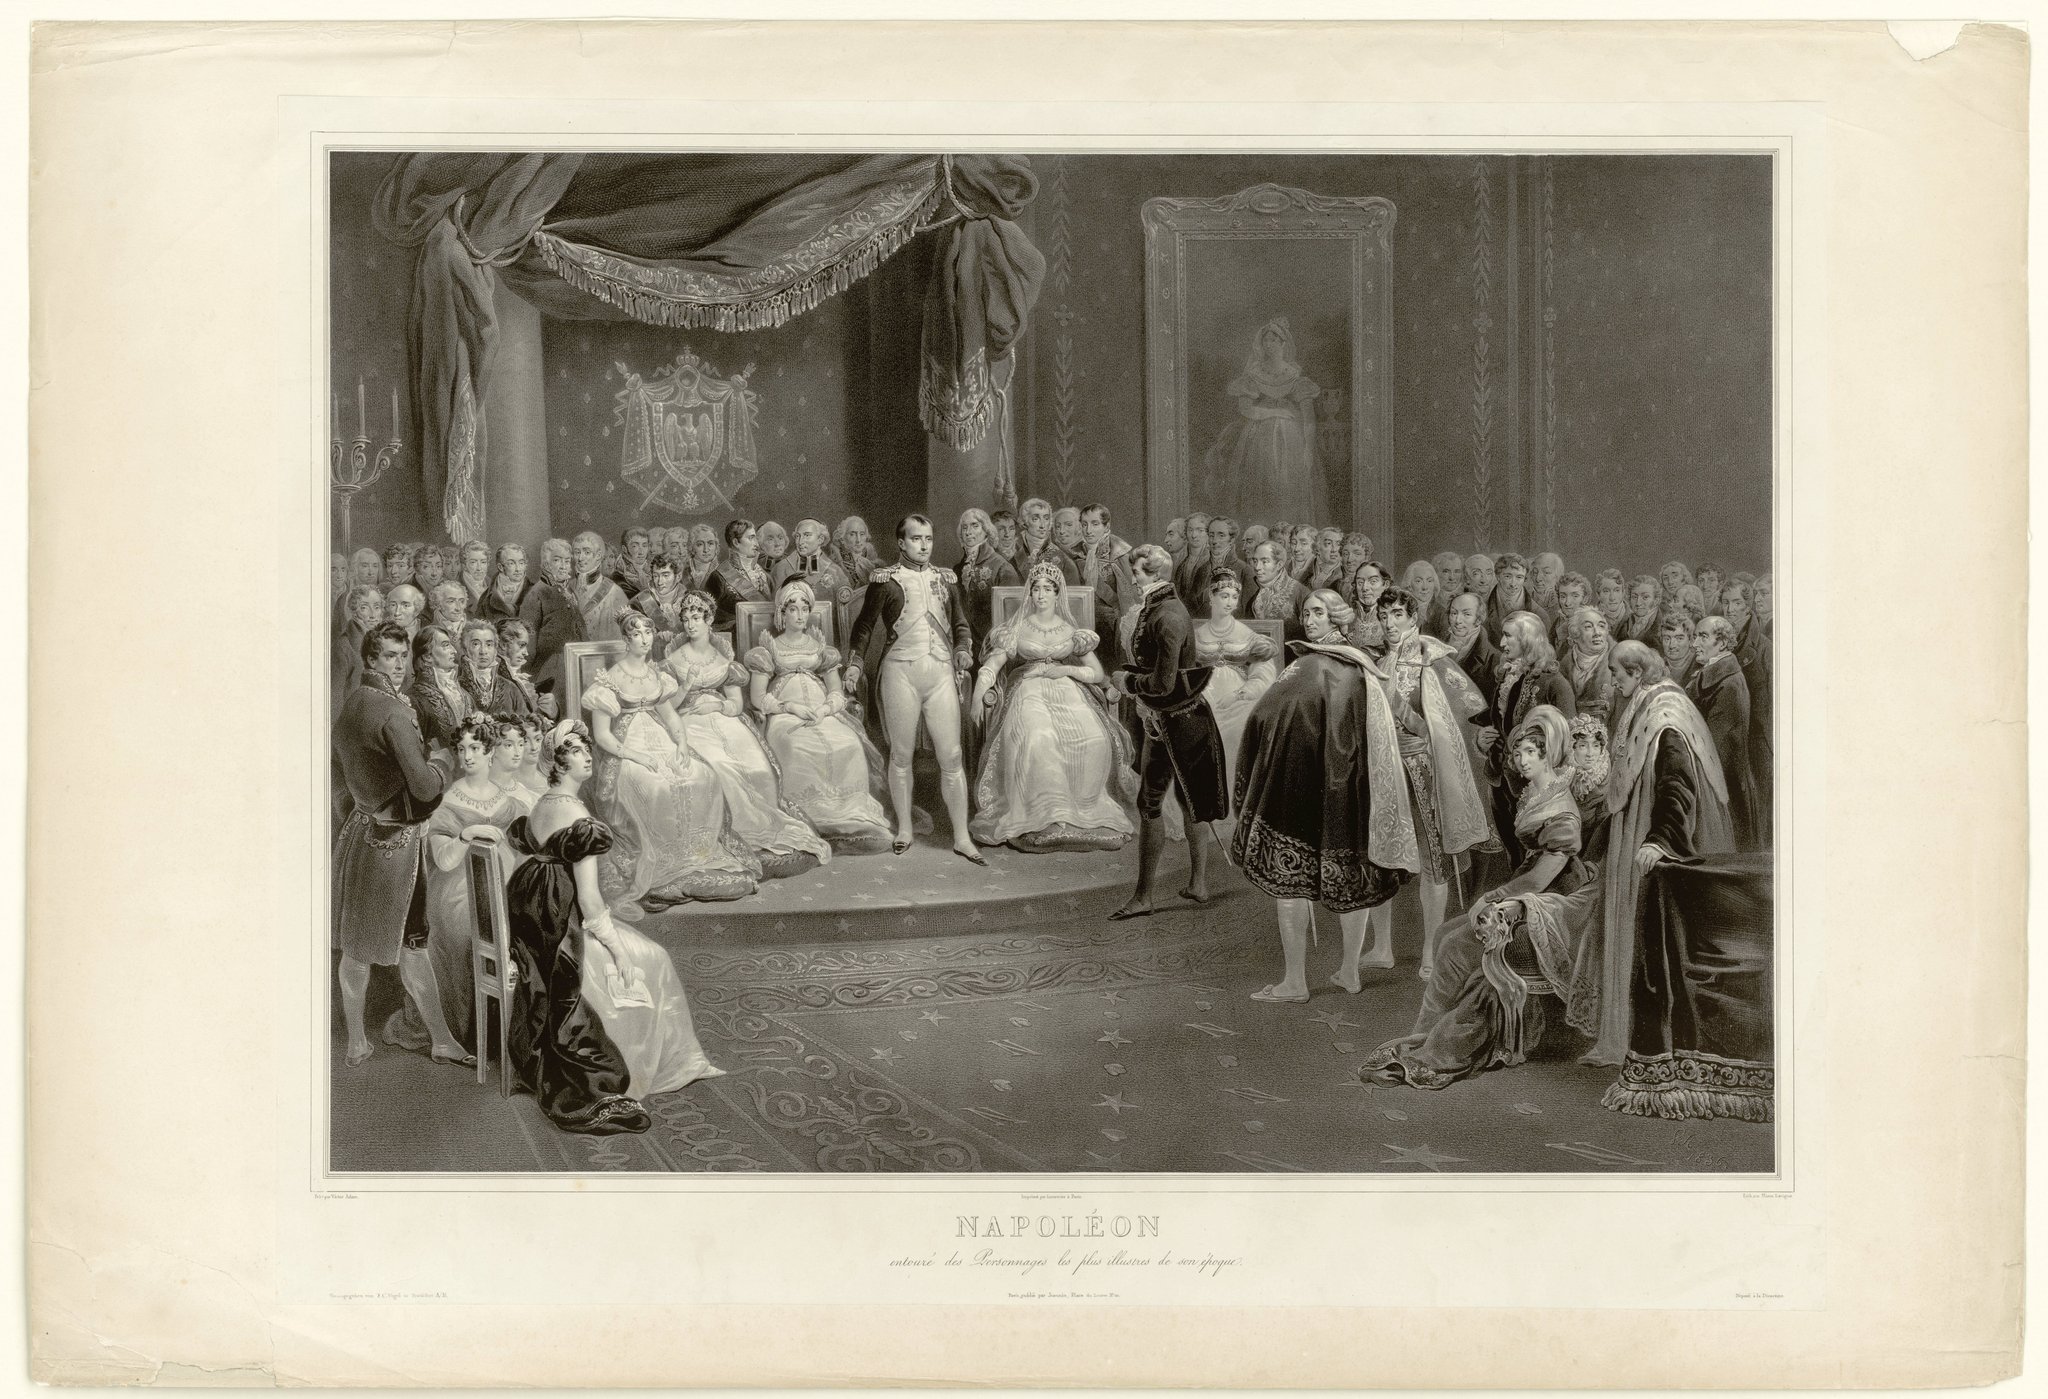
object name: print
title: Napoleon en zijn hof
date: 1807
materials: paper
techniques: lithograph